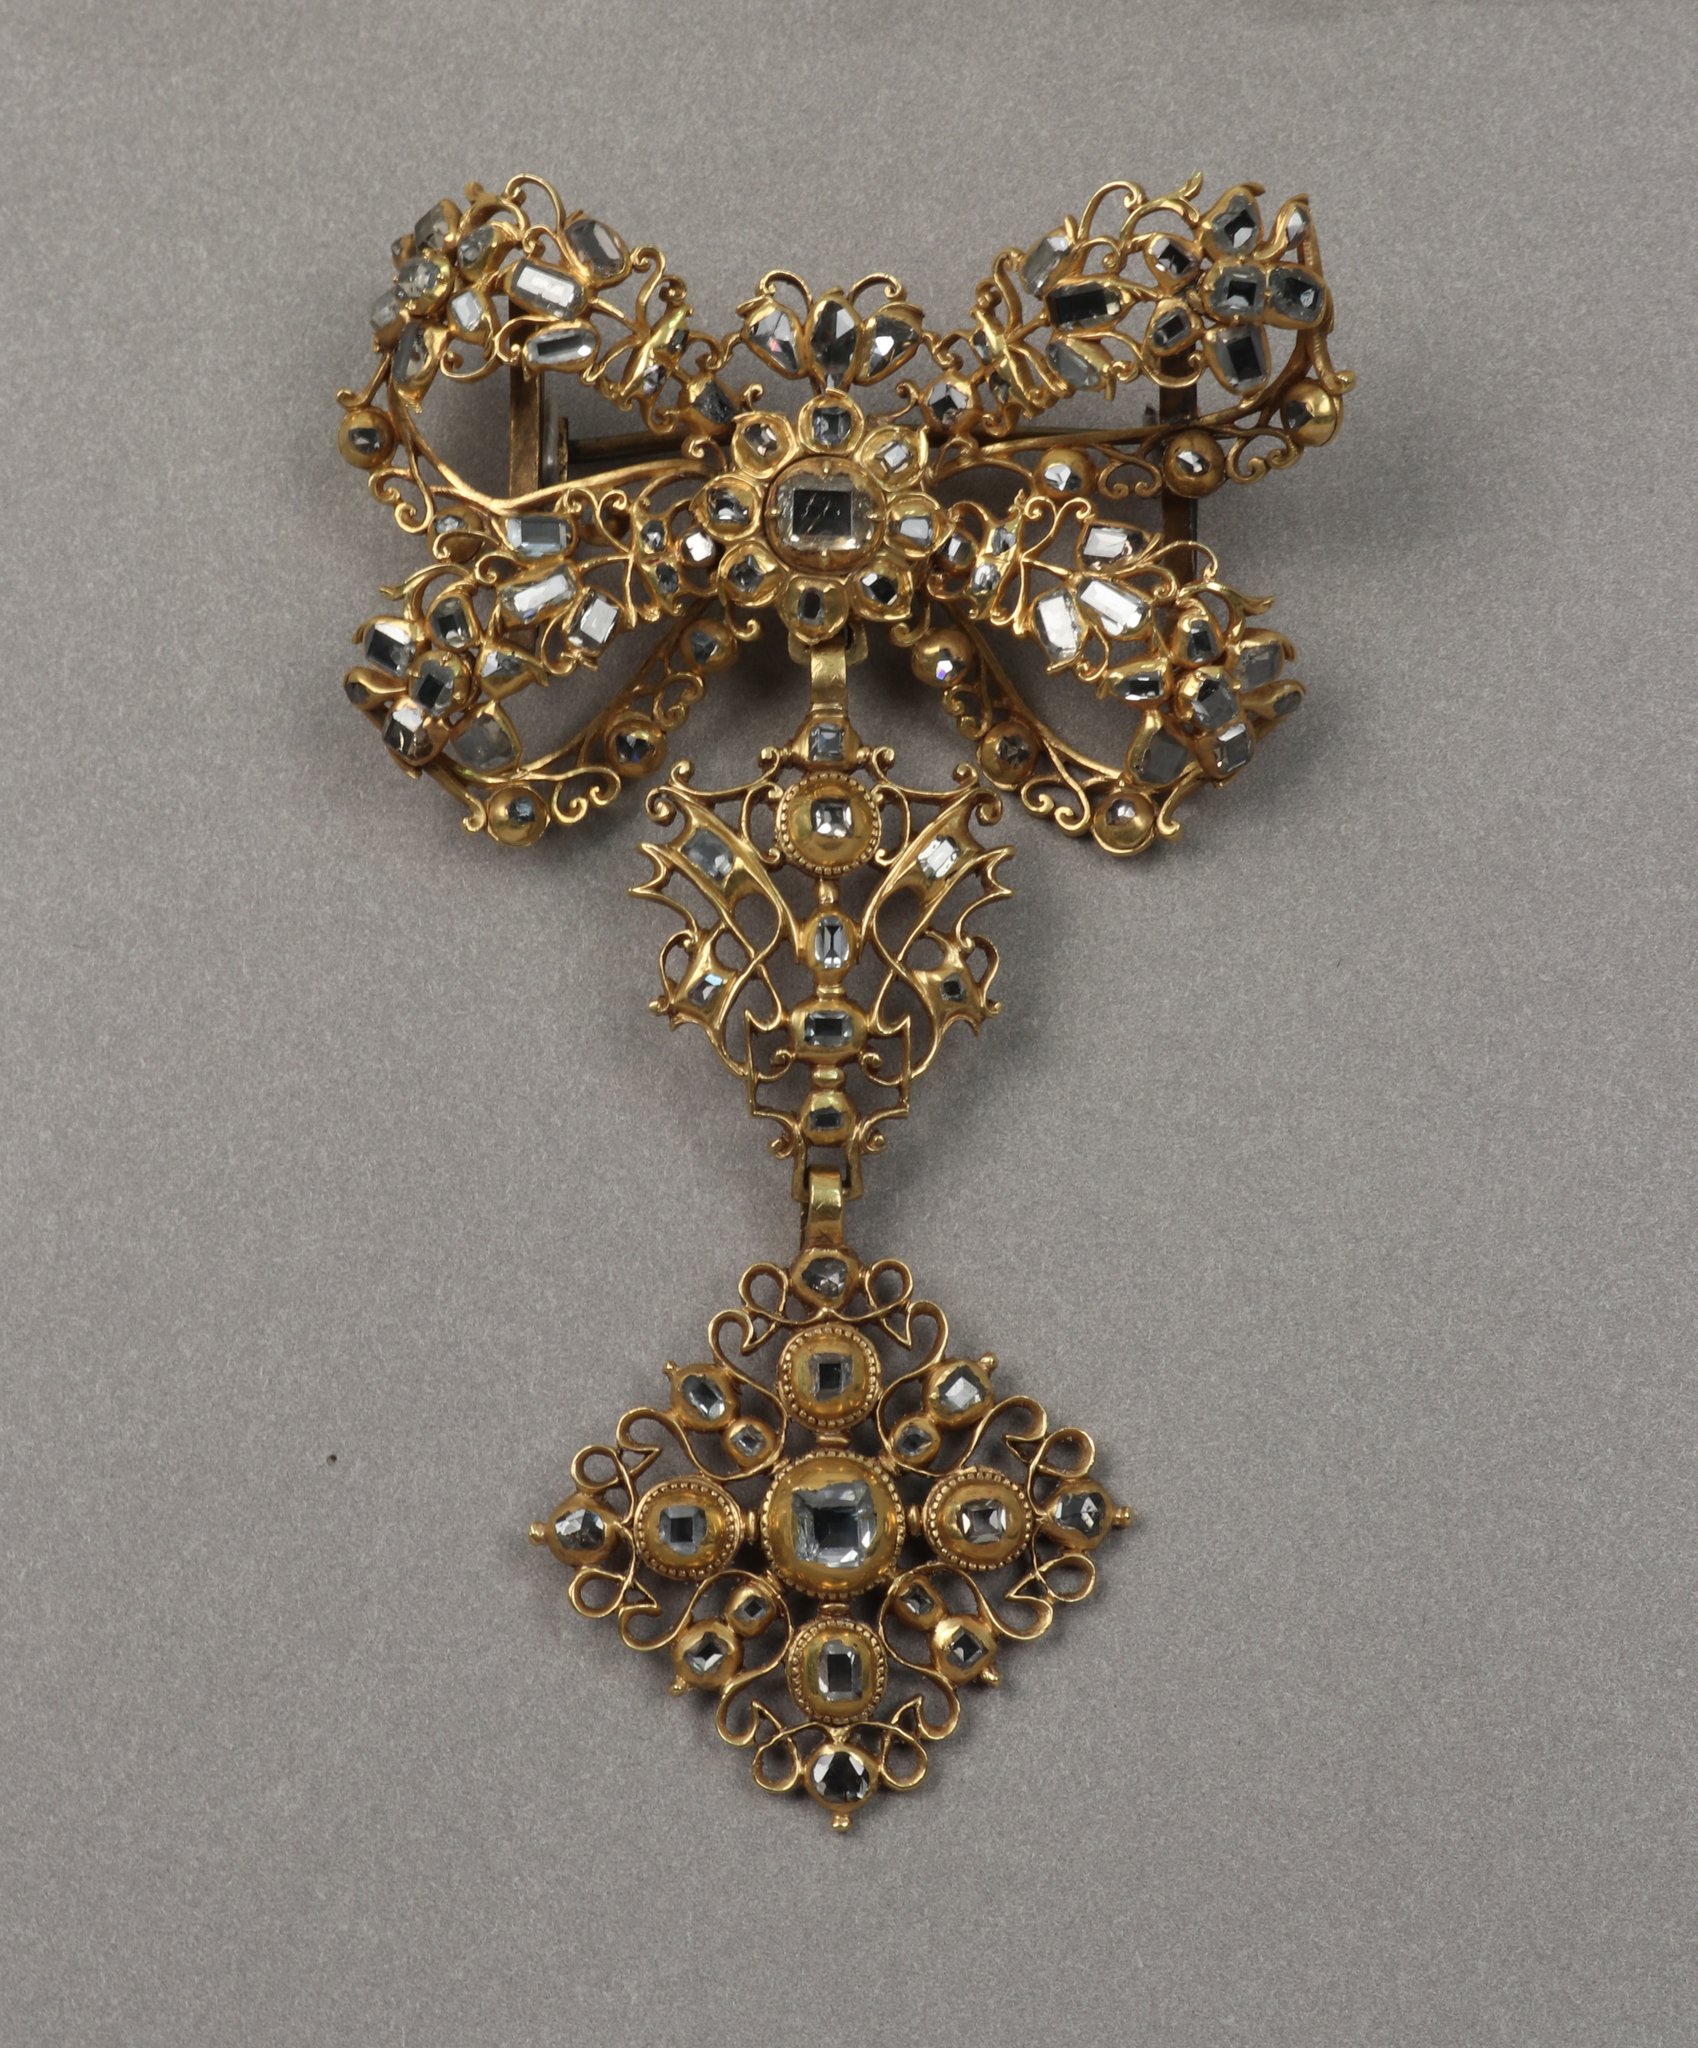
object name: brooch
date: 1701-1800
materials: diamond, gold